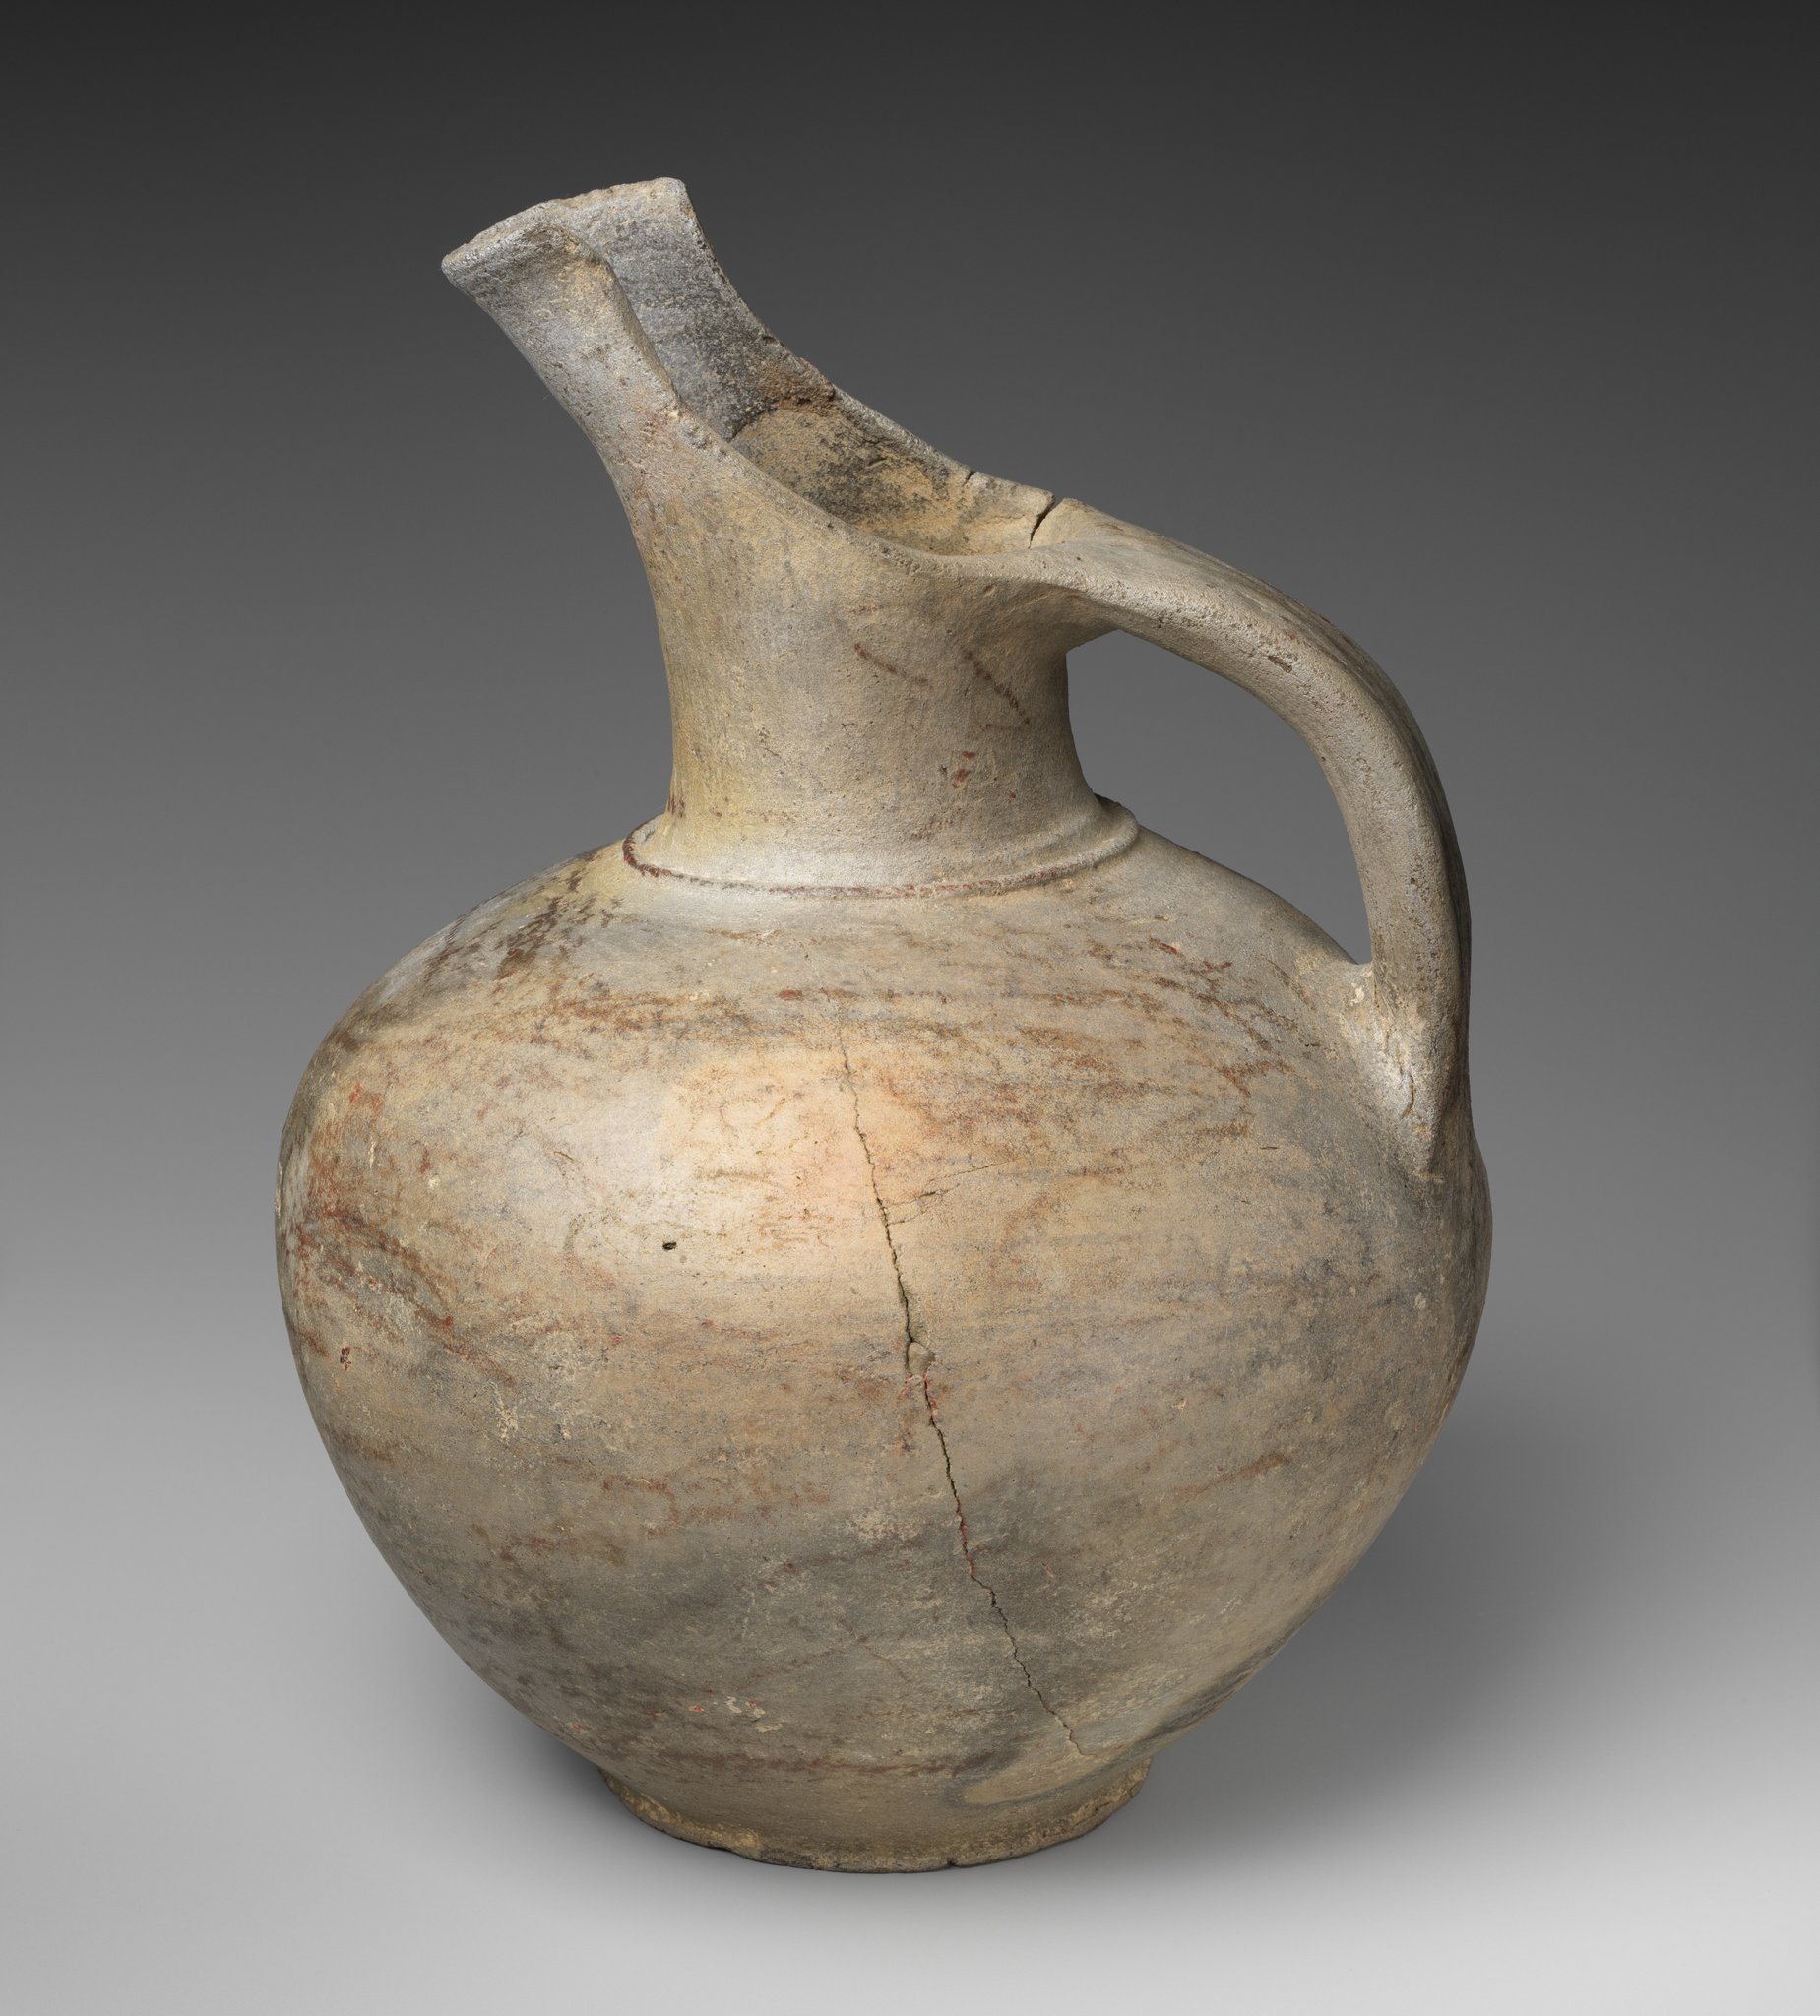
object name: jug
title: Terracotta spouted jug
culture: cycladic or cretan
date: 2700-2300 BCE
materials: terracotta